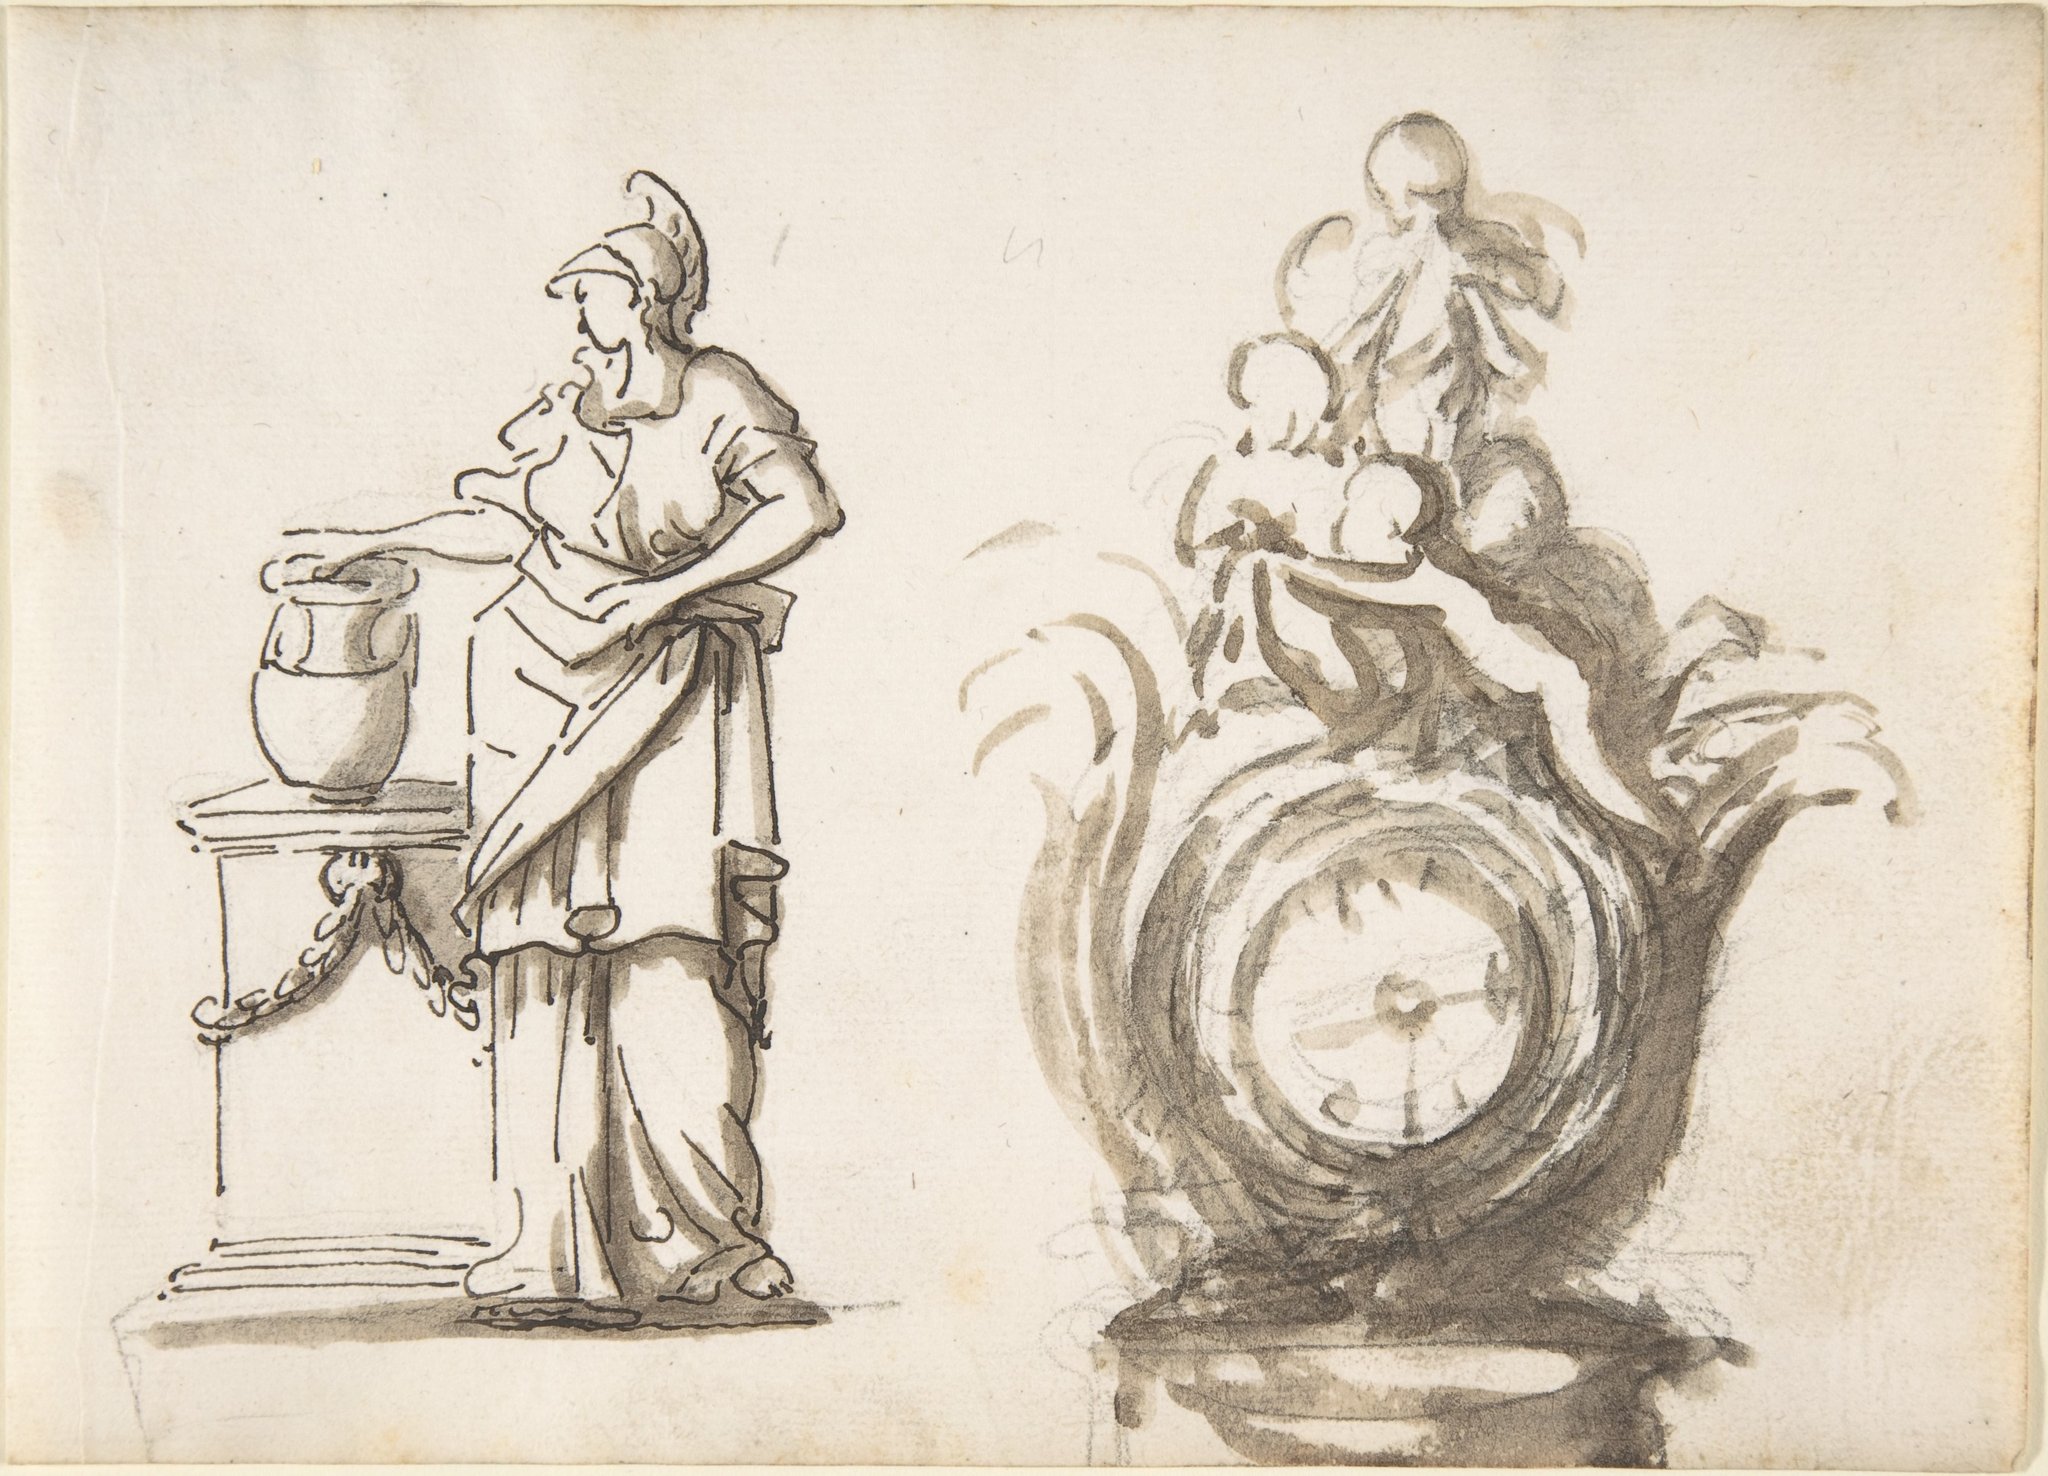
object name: drawing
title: Design for a Clock with a Classical Female Figure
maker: anonymous, french, 18th century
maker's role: artist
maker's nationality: french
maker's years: 1700-1800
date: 1800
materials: graphite, ink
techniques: brush, pen, wash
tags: women,clocks